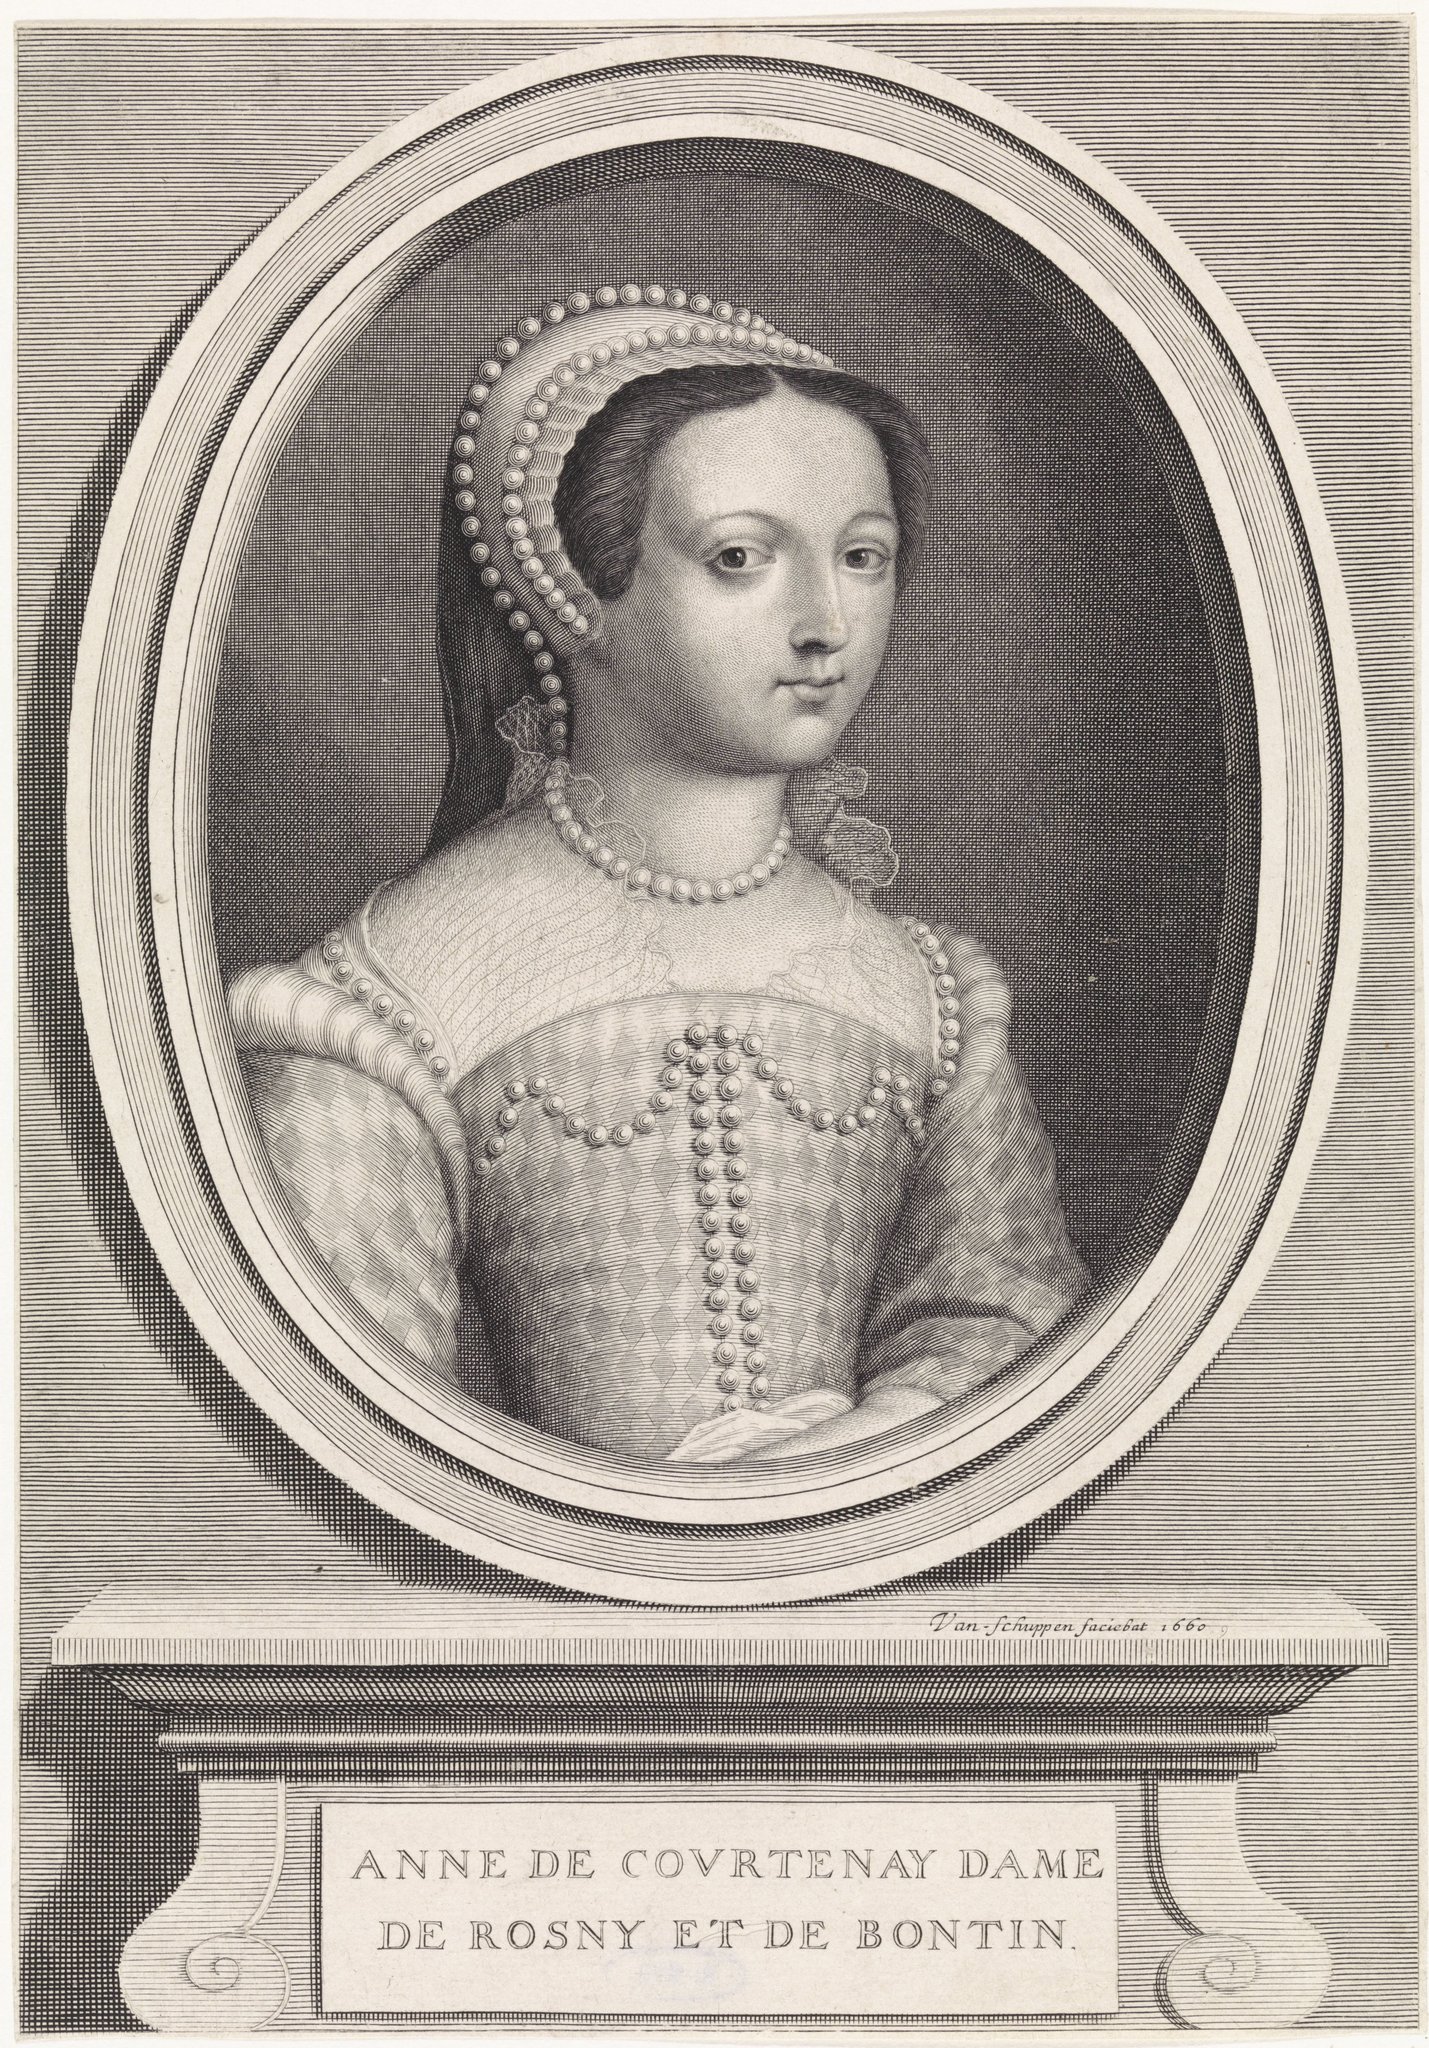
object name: print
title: Portret van Anne de Courtenay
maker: pieter van schuppen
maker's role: print maker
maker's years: 1627-1702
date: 1609-1660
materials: paper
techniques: engraving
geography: paris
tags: anne de courtenay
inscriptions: collector's mark: Lugt 2228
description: Portret van Anne de Courtenay, echtgenote van Maximilien (I) de Béthune, hertog van Sully.